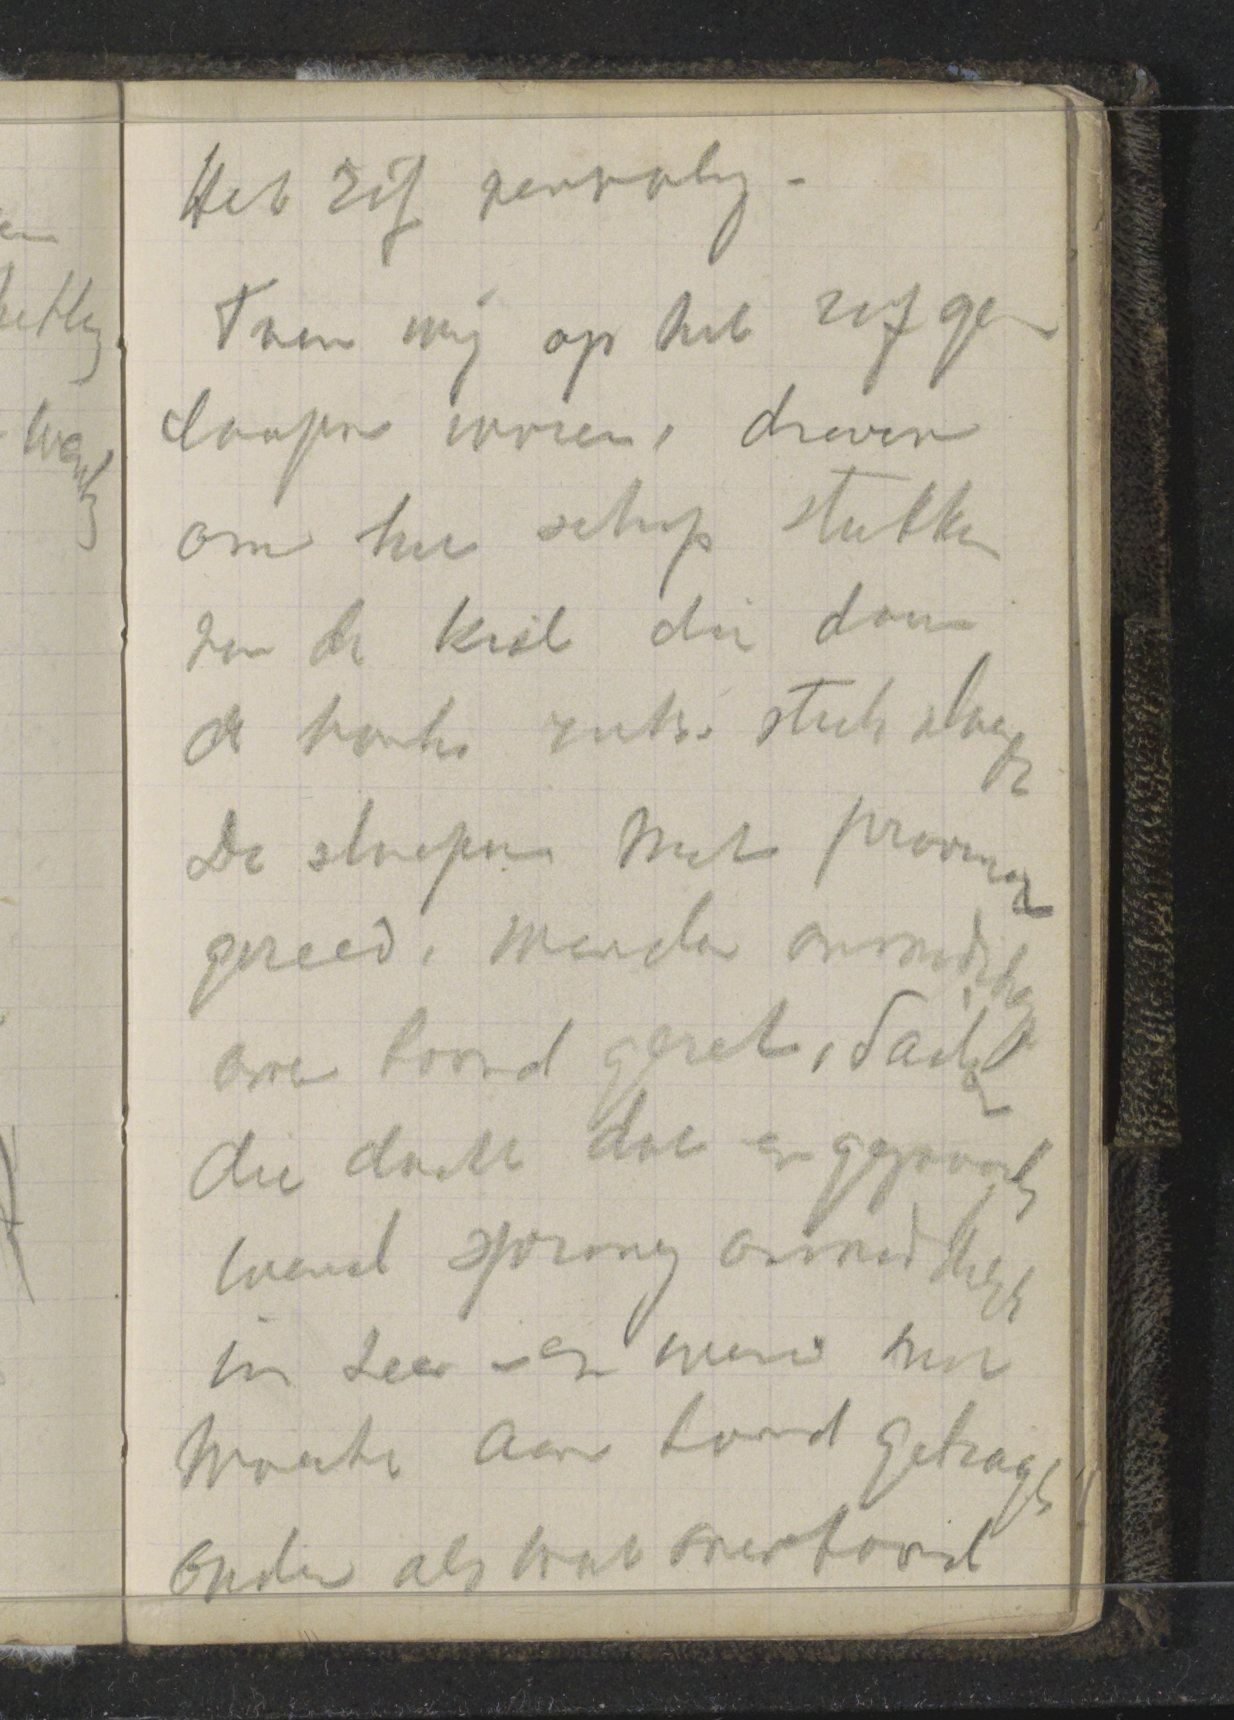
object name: sketchbook leaf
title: Reisverslag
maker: louis apol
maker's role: draughtsman, painter, print maker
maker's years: 1850-1936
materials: pencil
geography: novaya zemlya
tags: nova zembla expedities 1880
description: Blad 95 recto uit een schetsboek met 110 bladen betekend tijdens de expeditie naar Nova Zembla in 1880.